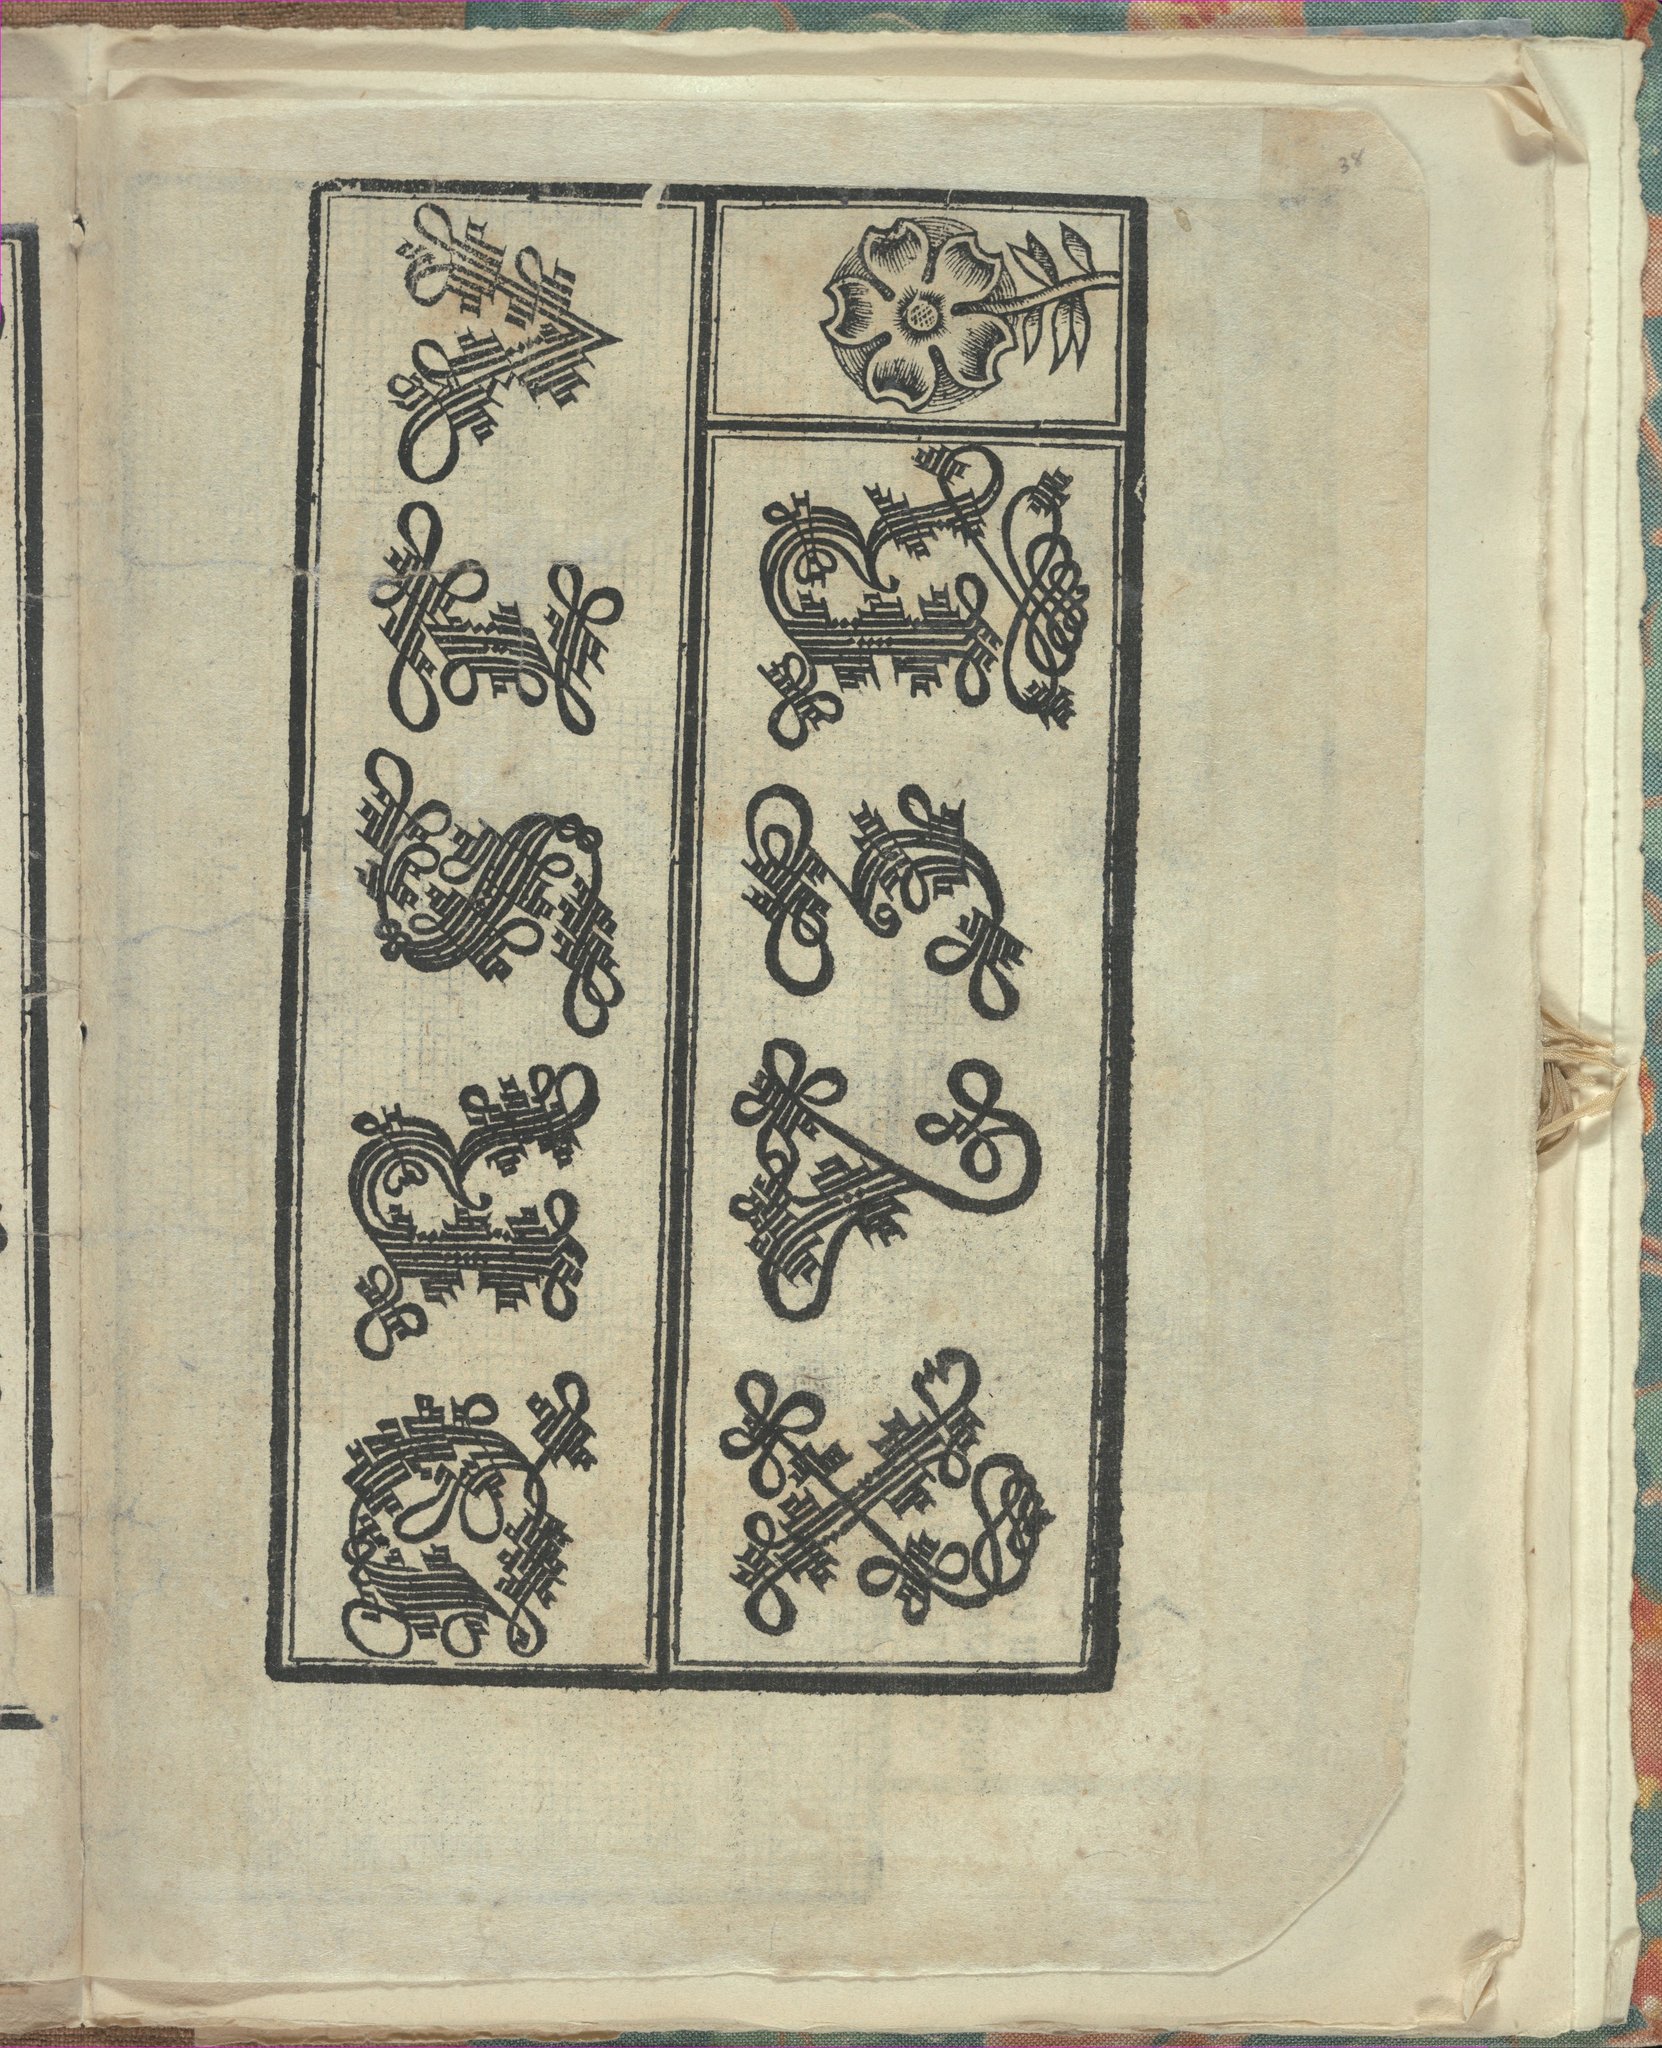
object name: book print ornament architecture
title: Opera Nova Universali intitulata Corona di racammi, page 38 (recto)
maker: giovanni andrea vavassore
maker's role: publisher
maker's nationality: italian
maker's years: 1530-1573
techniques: woodcut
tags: flowers